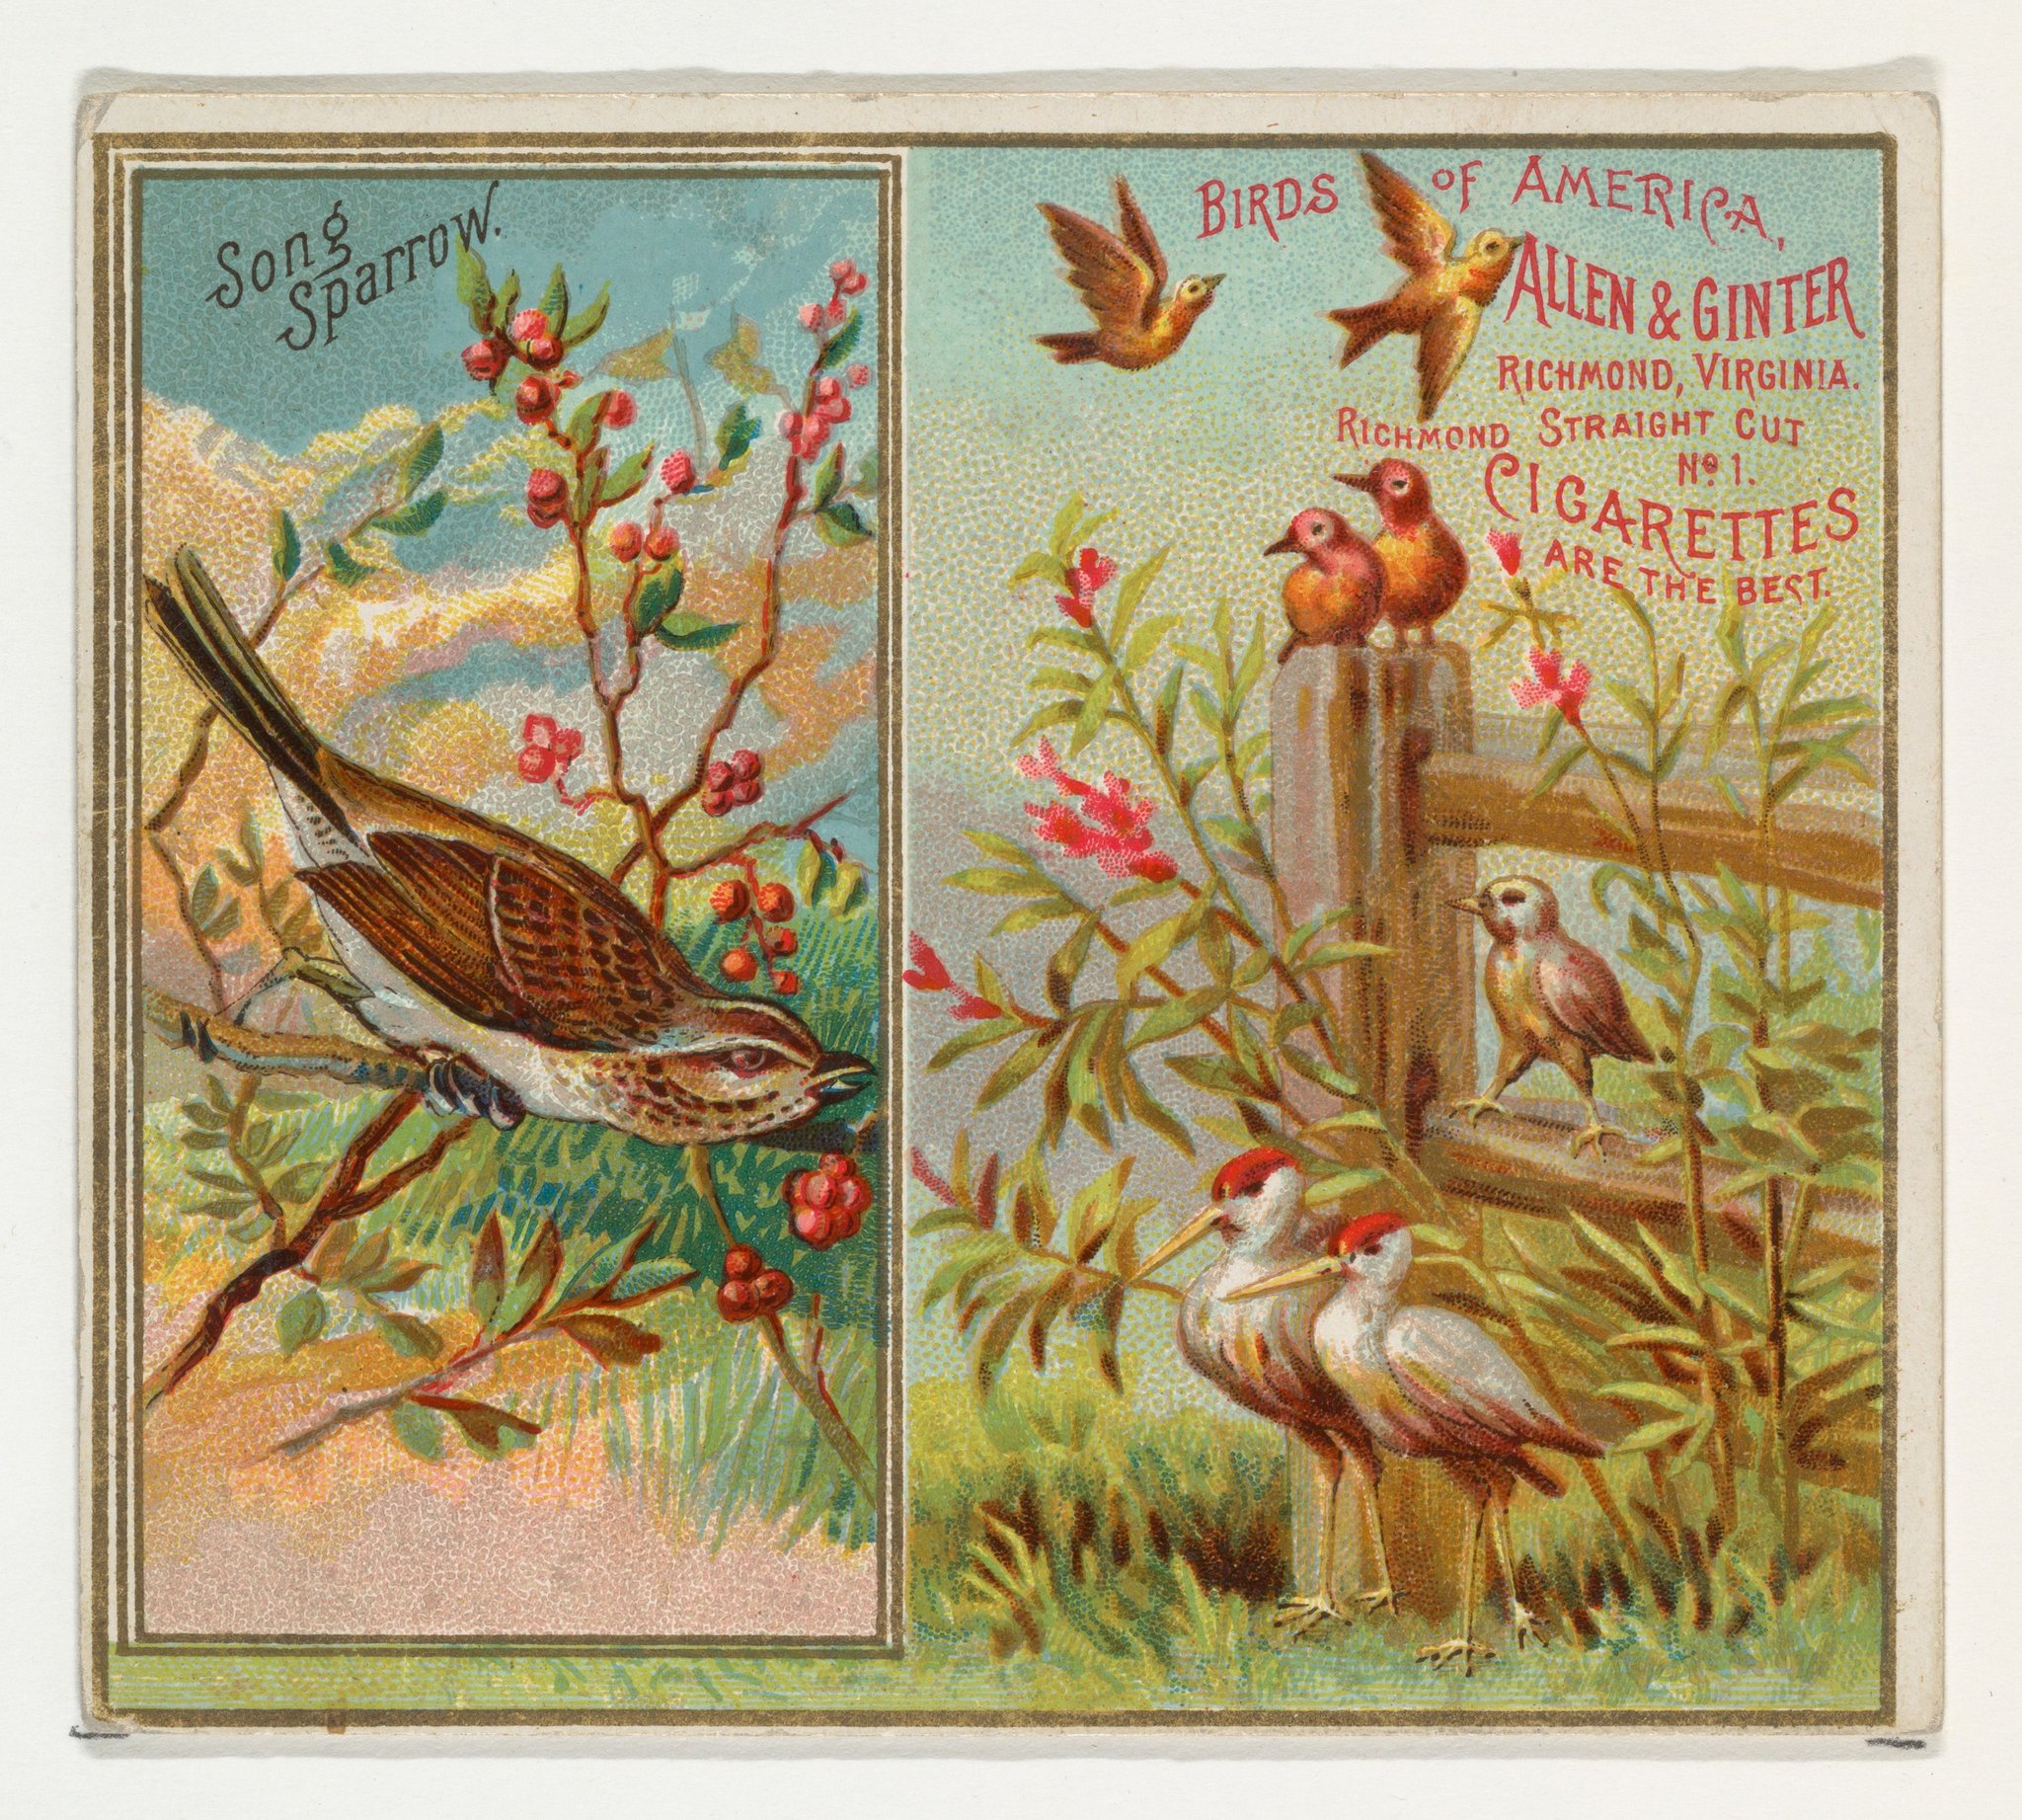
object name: print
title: Song Sparrow, from the Birds of America series (N37) for Allen & Ginter Cigarettes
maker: allen & ginter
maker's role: publisher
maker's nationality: american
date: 1888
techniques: color lithograph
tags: birds